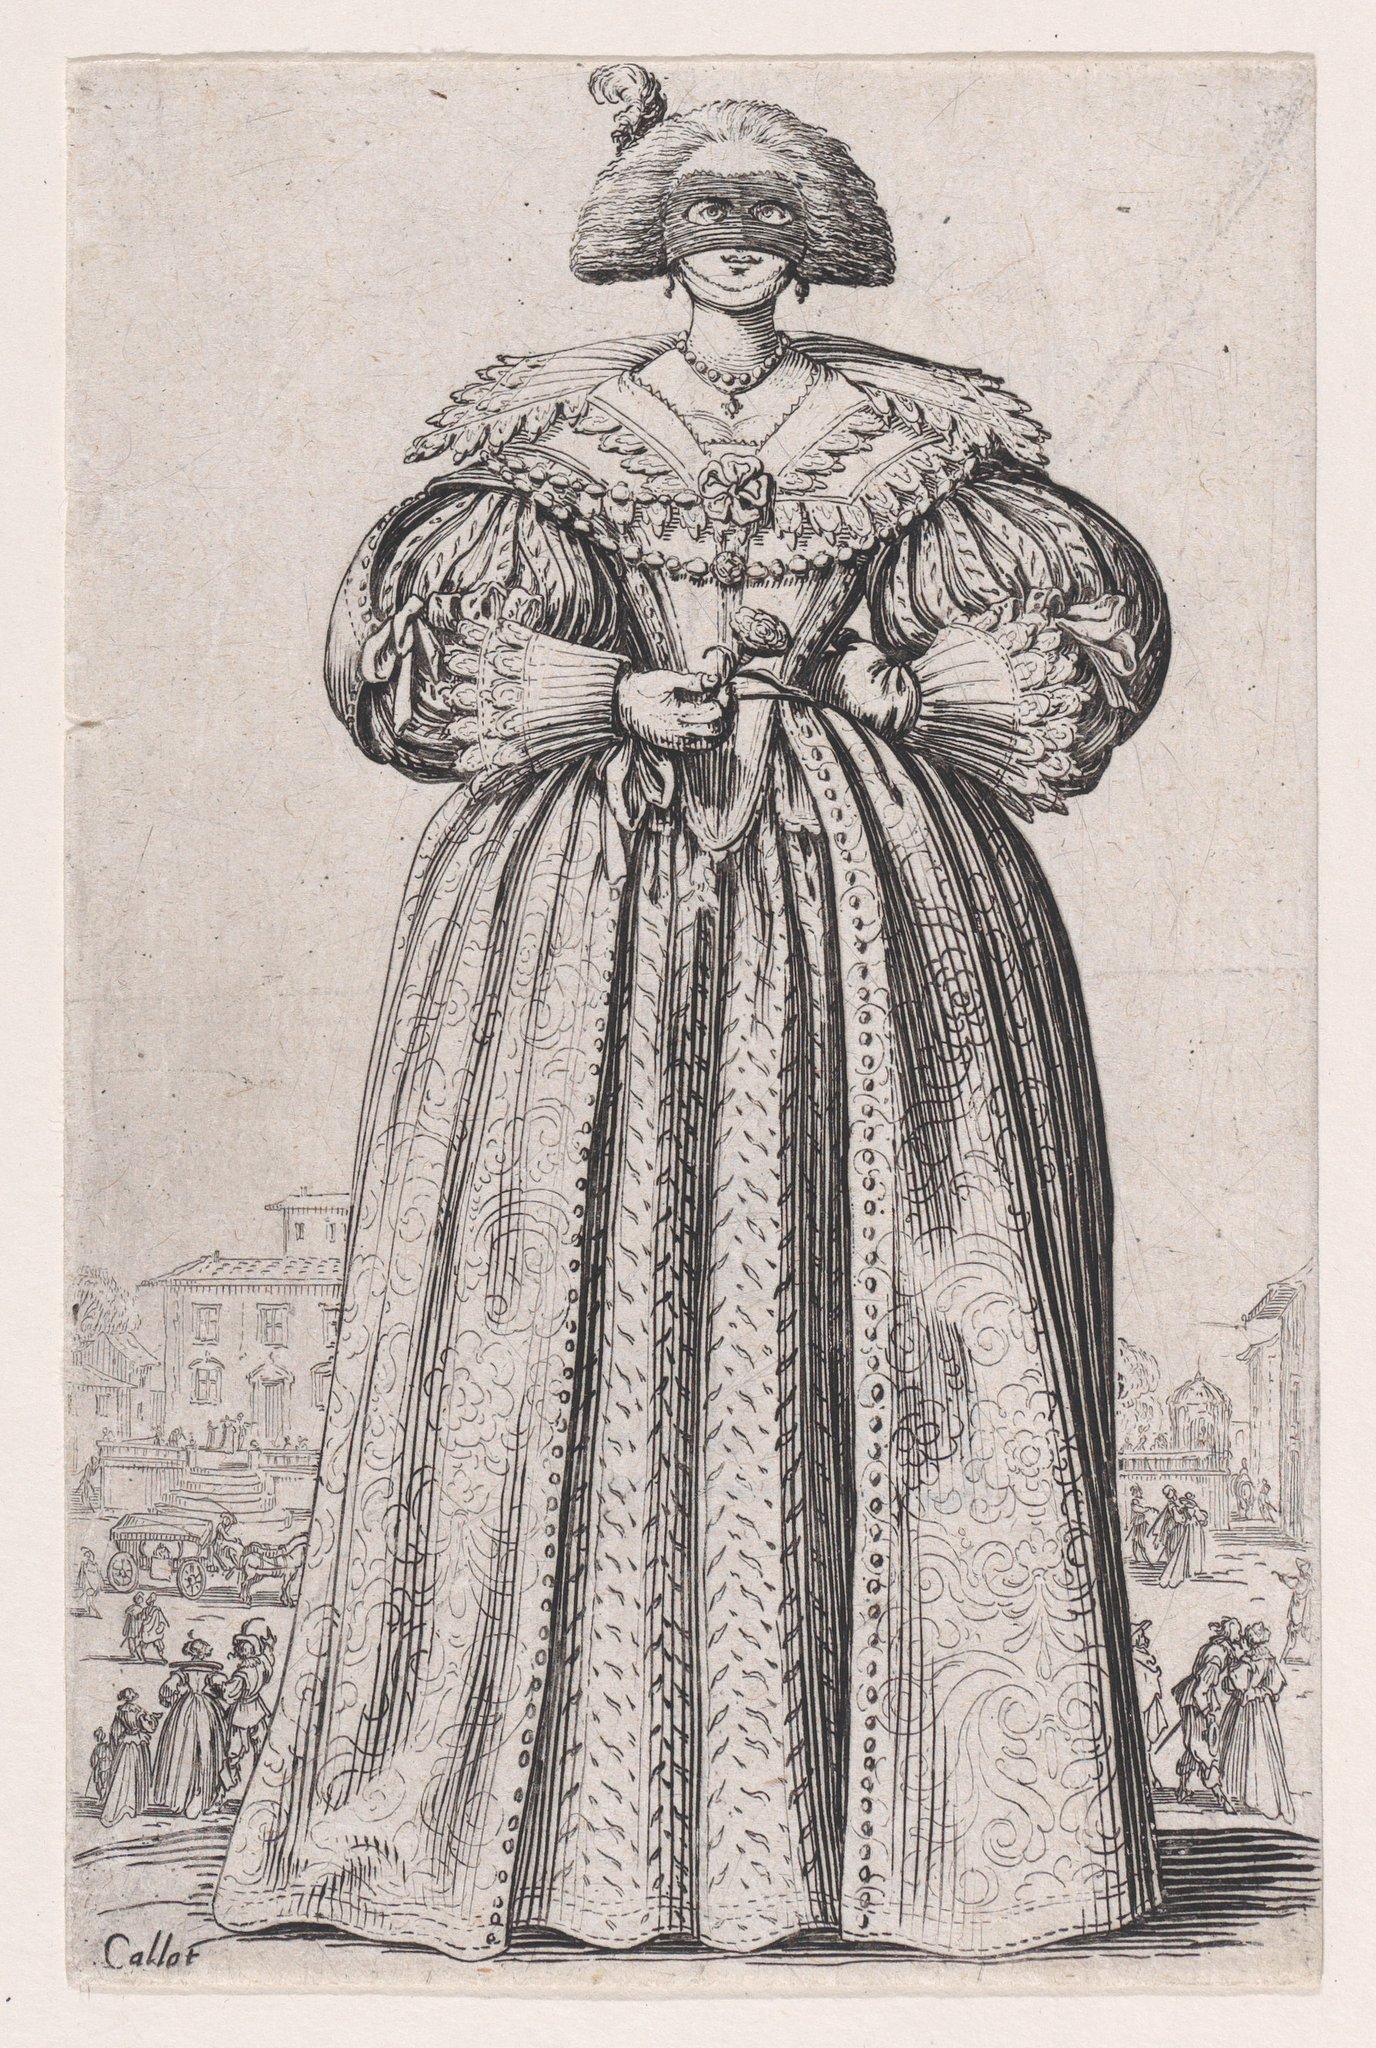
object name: print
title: La Dame au Masque (The Lady with a Mask), from "La Noblesse" (The Nobility)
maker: jacques callot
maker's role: artist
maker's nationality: french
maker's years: 1592-1635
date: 1623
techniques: etching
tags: masks,women